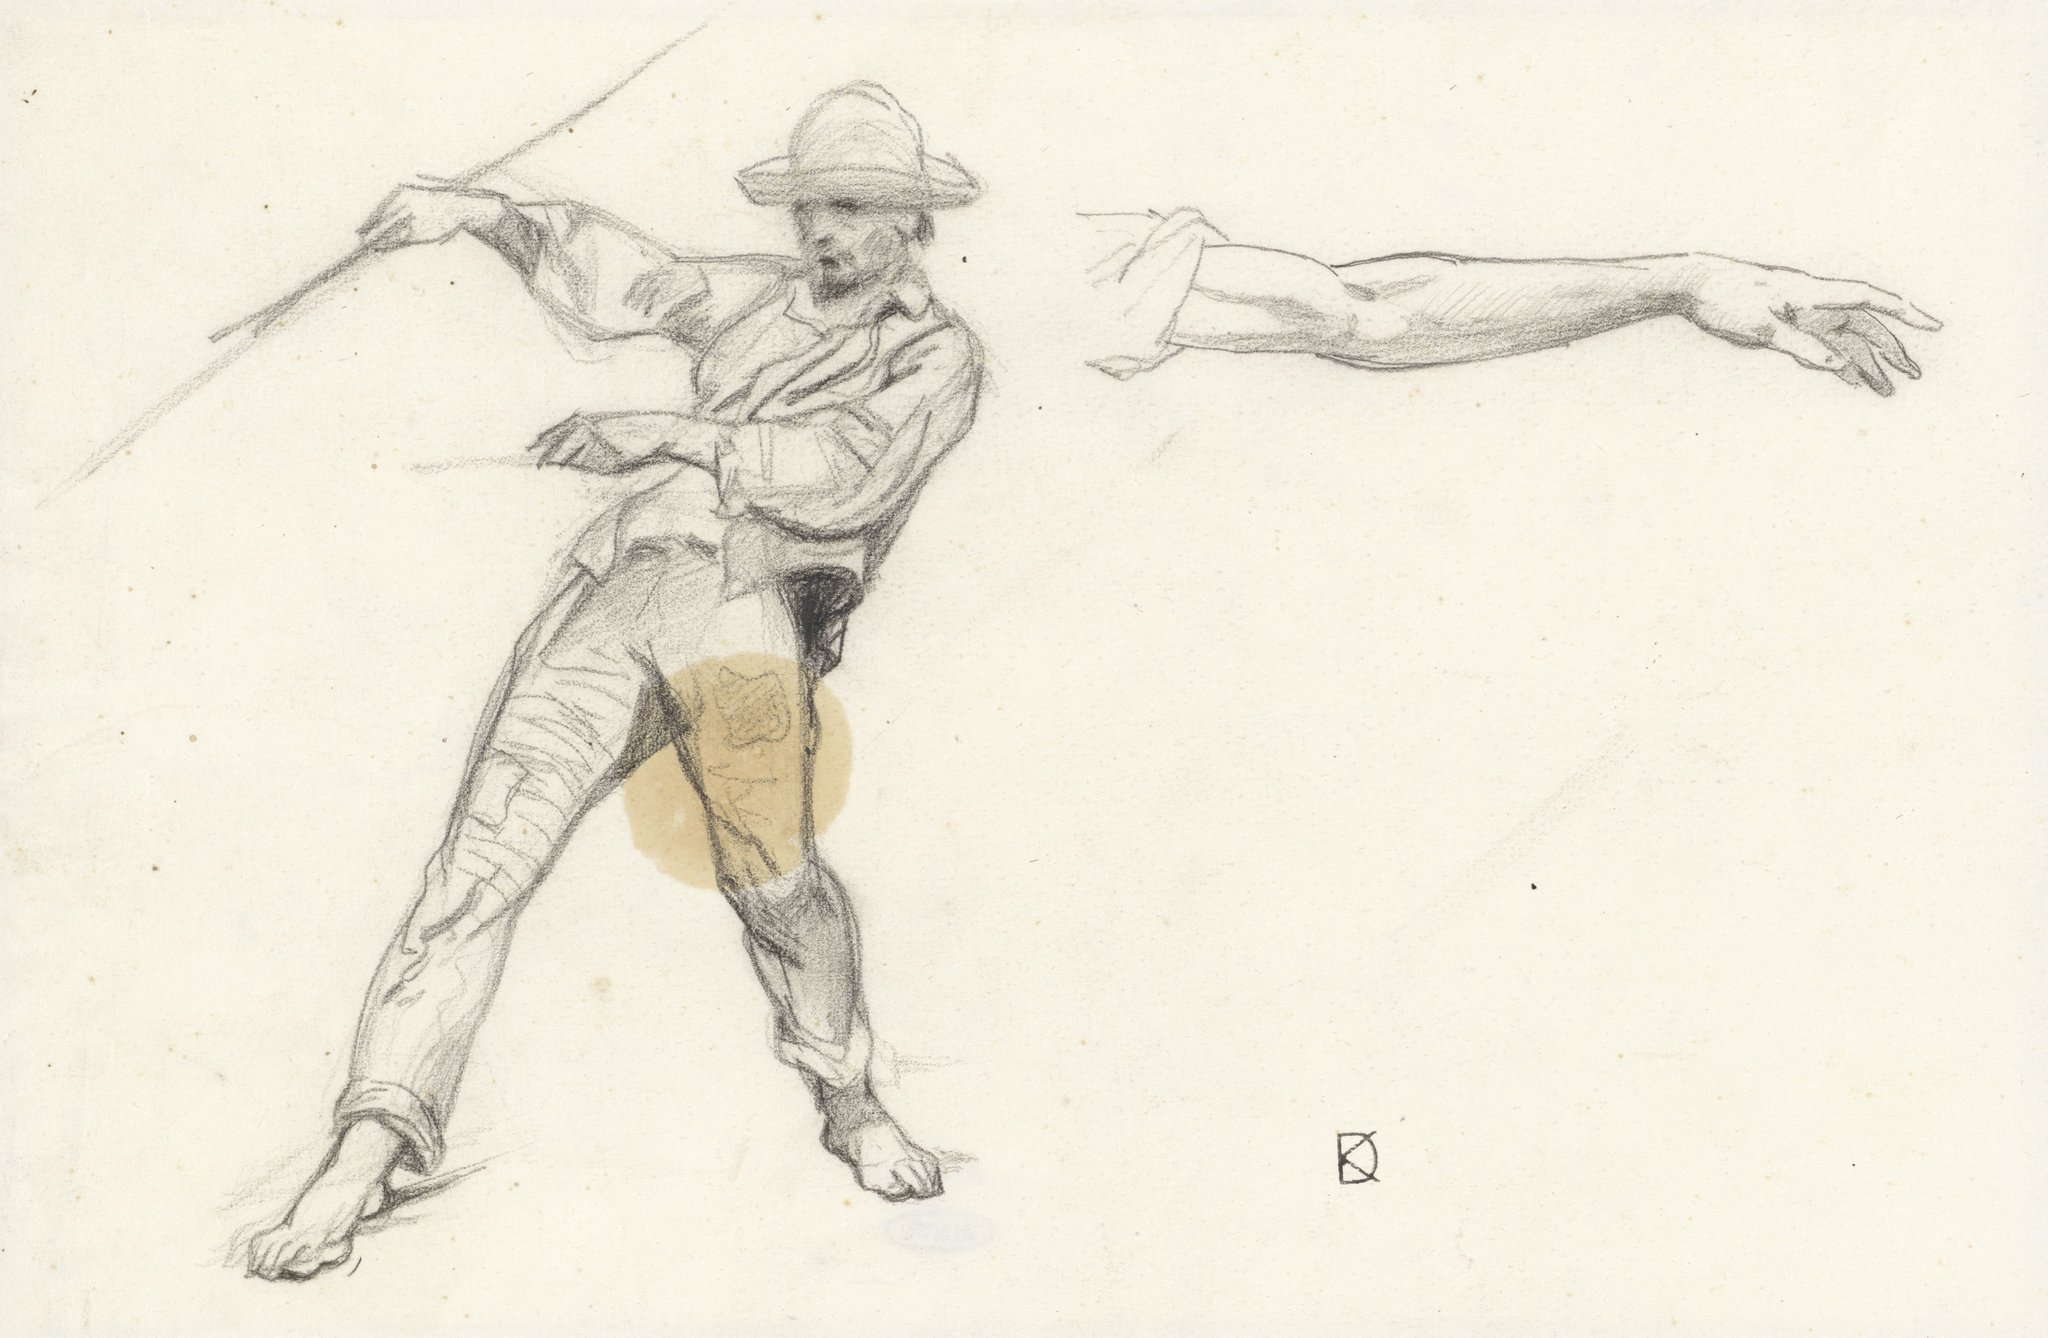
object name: drawing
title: Studie van een staande man en een arm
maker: johan daniël koelman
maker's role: draughtsman, print maker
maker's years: 1831-1857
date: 1841-1857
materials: chalk, paper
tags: standing figure, arms, male sex; man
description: Studie van een staande man, achterover geleund met stok in de hand en een studie van een arm.